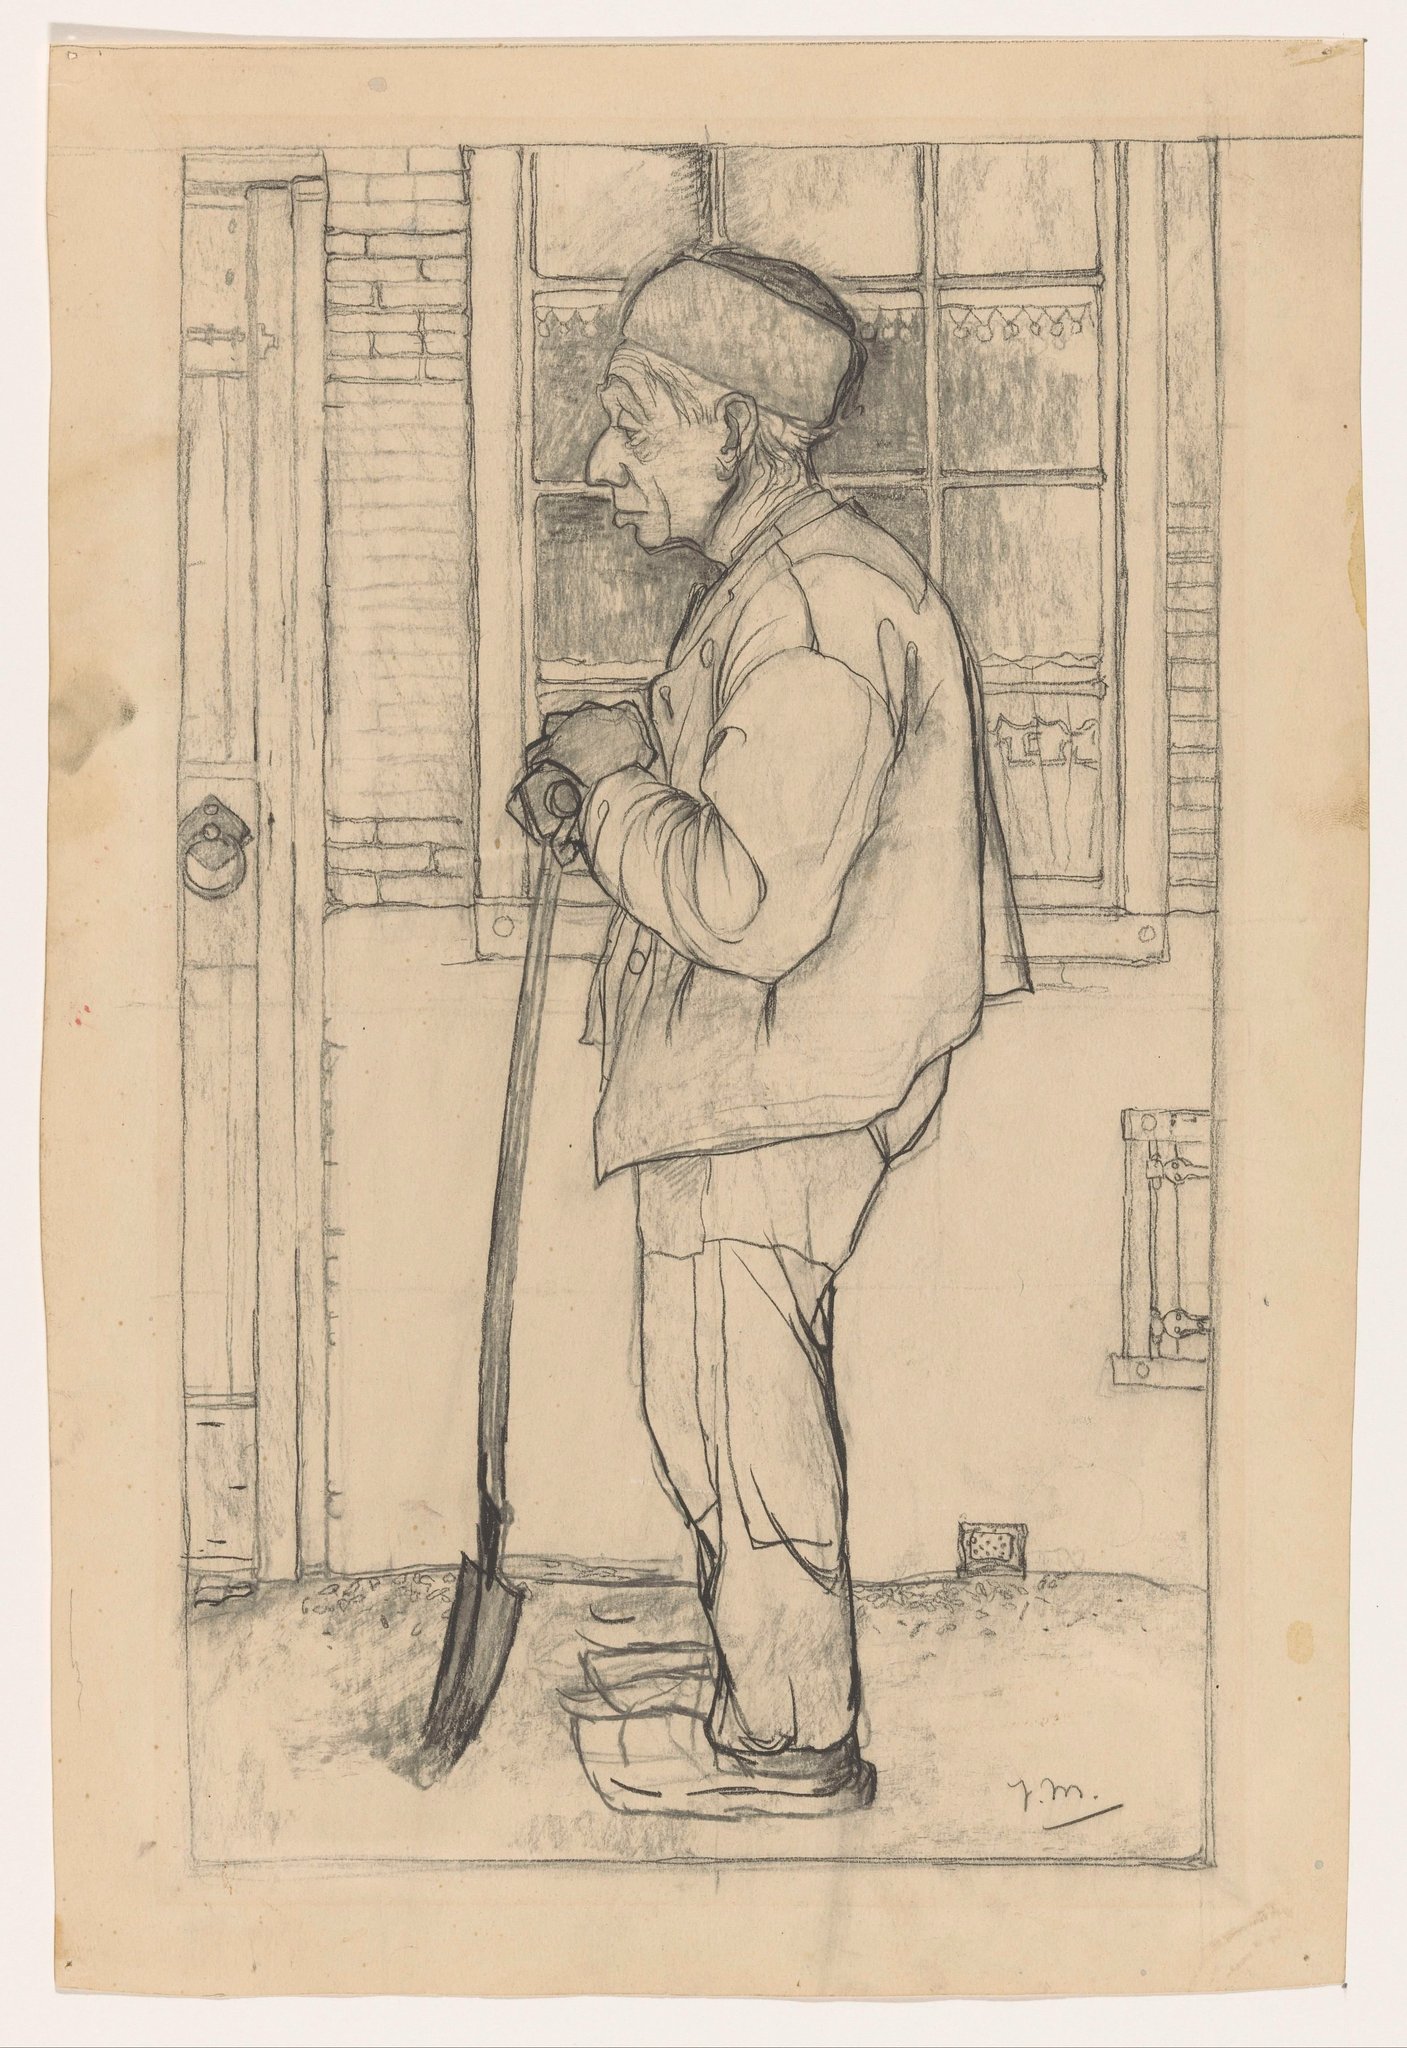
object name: drawing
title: Douwe de Groot met een spade voor het huis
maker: jan mankes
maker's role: draughtsman, painter, print maker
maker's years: 1889-1920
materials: chalk, charcoal, paper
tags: historical persons, old man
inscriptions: collector's mark: Lugt 2228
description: Ontwerp voor het schilderij: Douwe voor het huis, 1915.